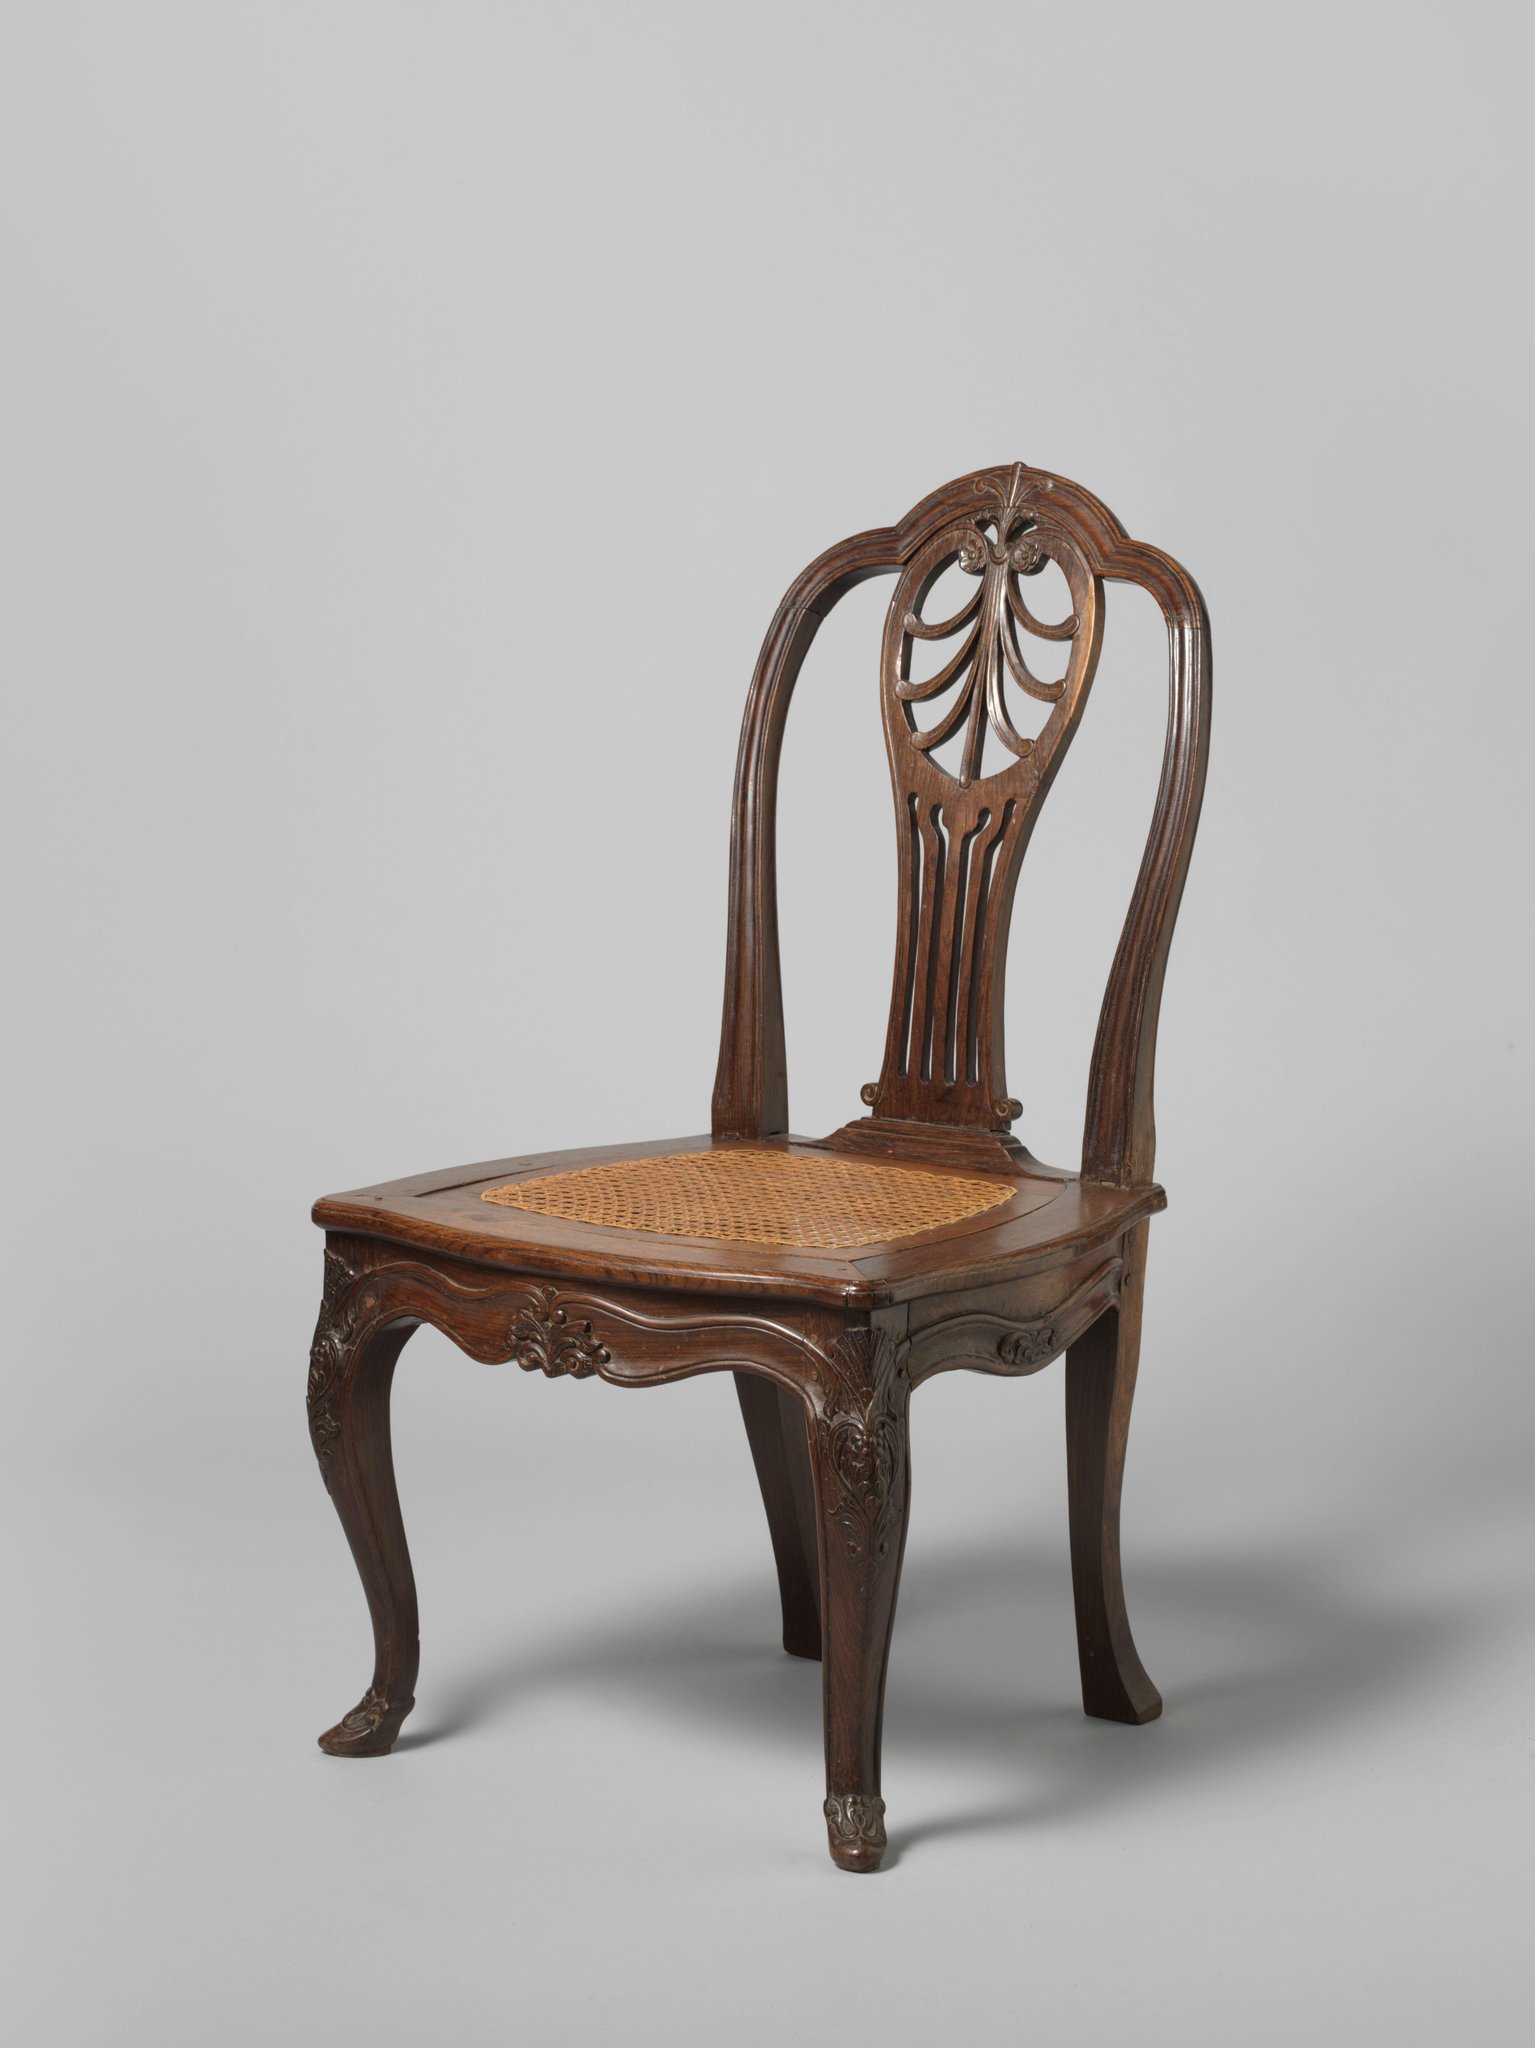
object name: chair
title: Stoel met zitting van gevlochten rotan, S-vormige overhoeks geplaatste voorpoten en zitregels versierd met gerekt S-vormige profileringen en bladwerk. bovendorpel met palmet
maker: Anonymous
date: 1750-1775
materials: rattan, wood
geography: indonesia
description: Stoel van djatihout met een zitting van gevlochten rotan. De S-vormige overhoeks geplaatste voorpoten en de zitregels zijn versierd met gerekt S-vormige profileringen en bladwerk. De achterwaarts wijkende hoekige achterpoten gaan over in de gerekt S-vormige geprofileerde rugstijlen. De gebogen bovendorpel toont in het midden een gebeeldhouwde palmet. Het opengewerkte middenblad heeft gerekt S-vormige zijden, bovenaan toegewend en versierd met rozetten, zij omvatten daar een opengewerkte palmetvorm.